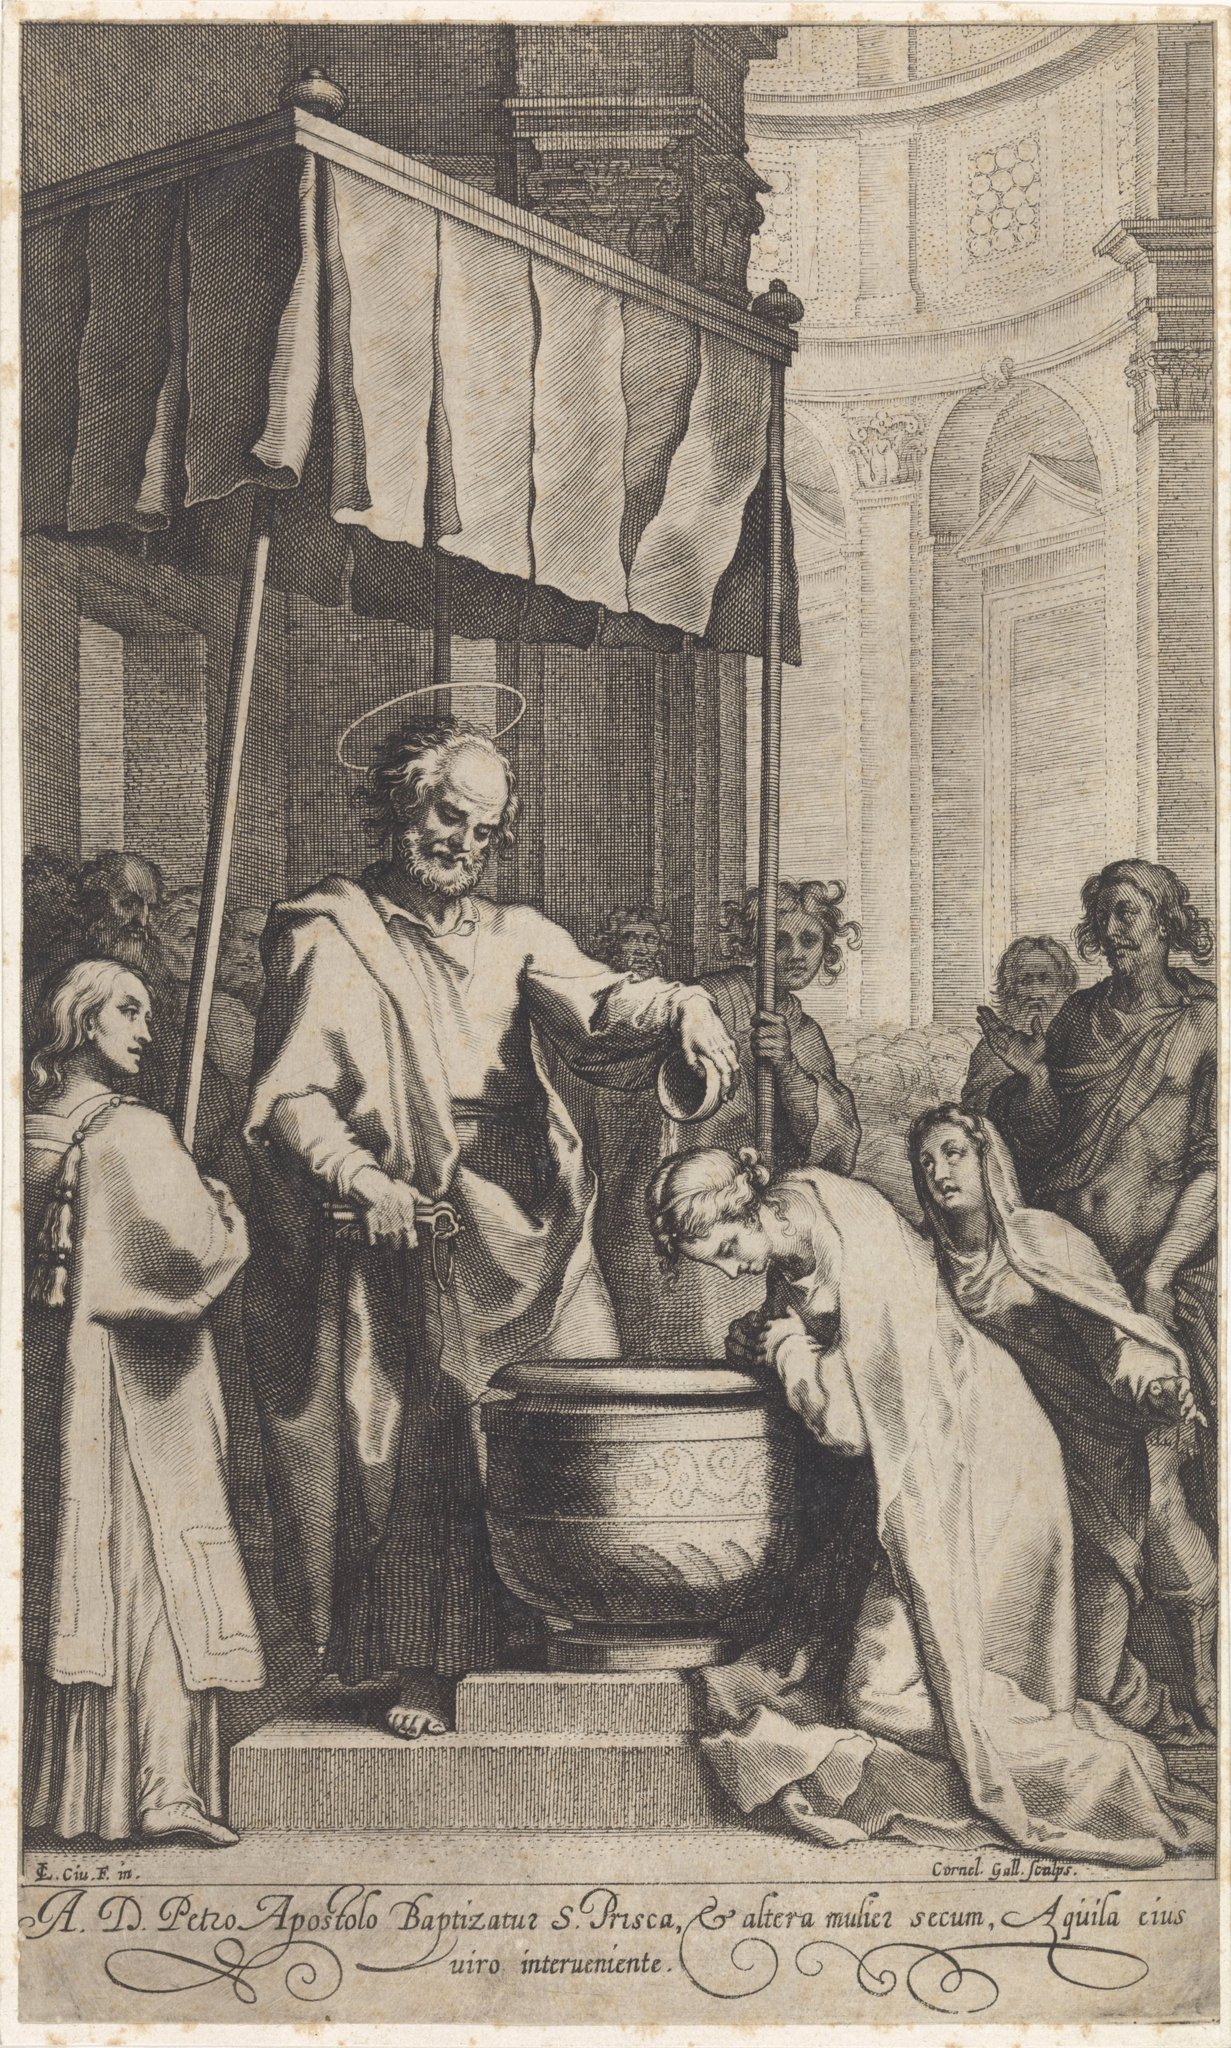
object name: print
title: Petrus doopt de H. Prisca van Rome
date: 1586-1610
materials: paper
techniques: engraving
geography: italy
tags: baptismal font, the apostle peter, first bishop of rome; possible attributes: book, cock, (upturned) cross, (triple) crozier, fish, key, scroll, ship, tiara, female saints (with name) - baptism, consecration, taking vows of female saint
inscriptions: collector's mark: Lugt 2228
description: De heilige Petrus, met de sleutels in zijn hand, doopt de heilige Prisca van Rome. Prisca knielt voor een doopvond met gevouwen handen. Petrus giet uit een kommetje water over haar hoofd. Een tweede vrouw knielt achter Prisca en wacht haar beurt af.